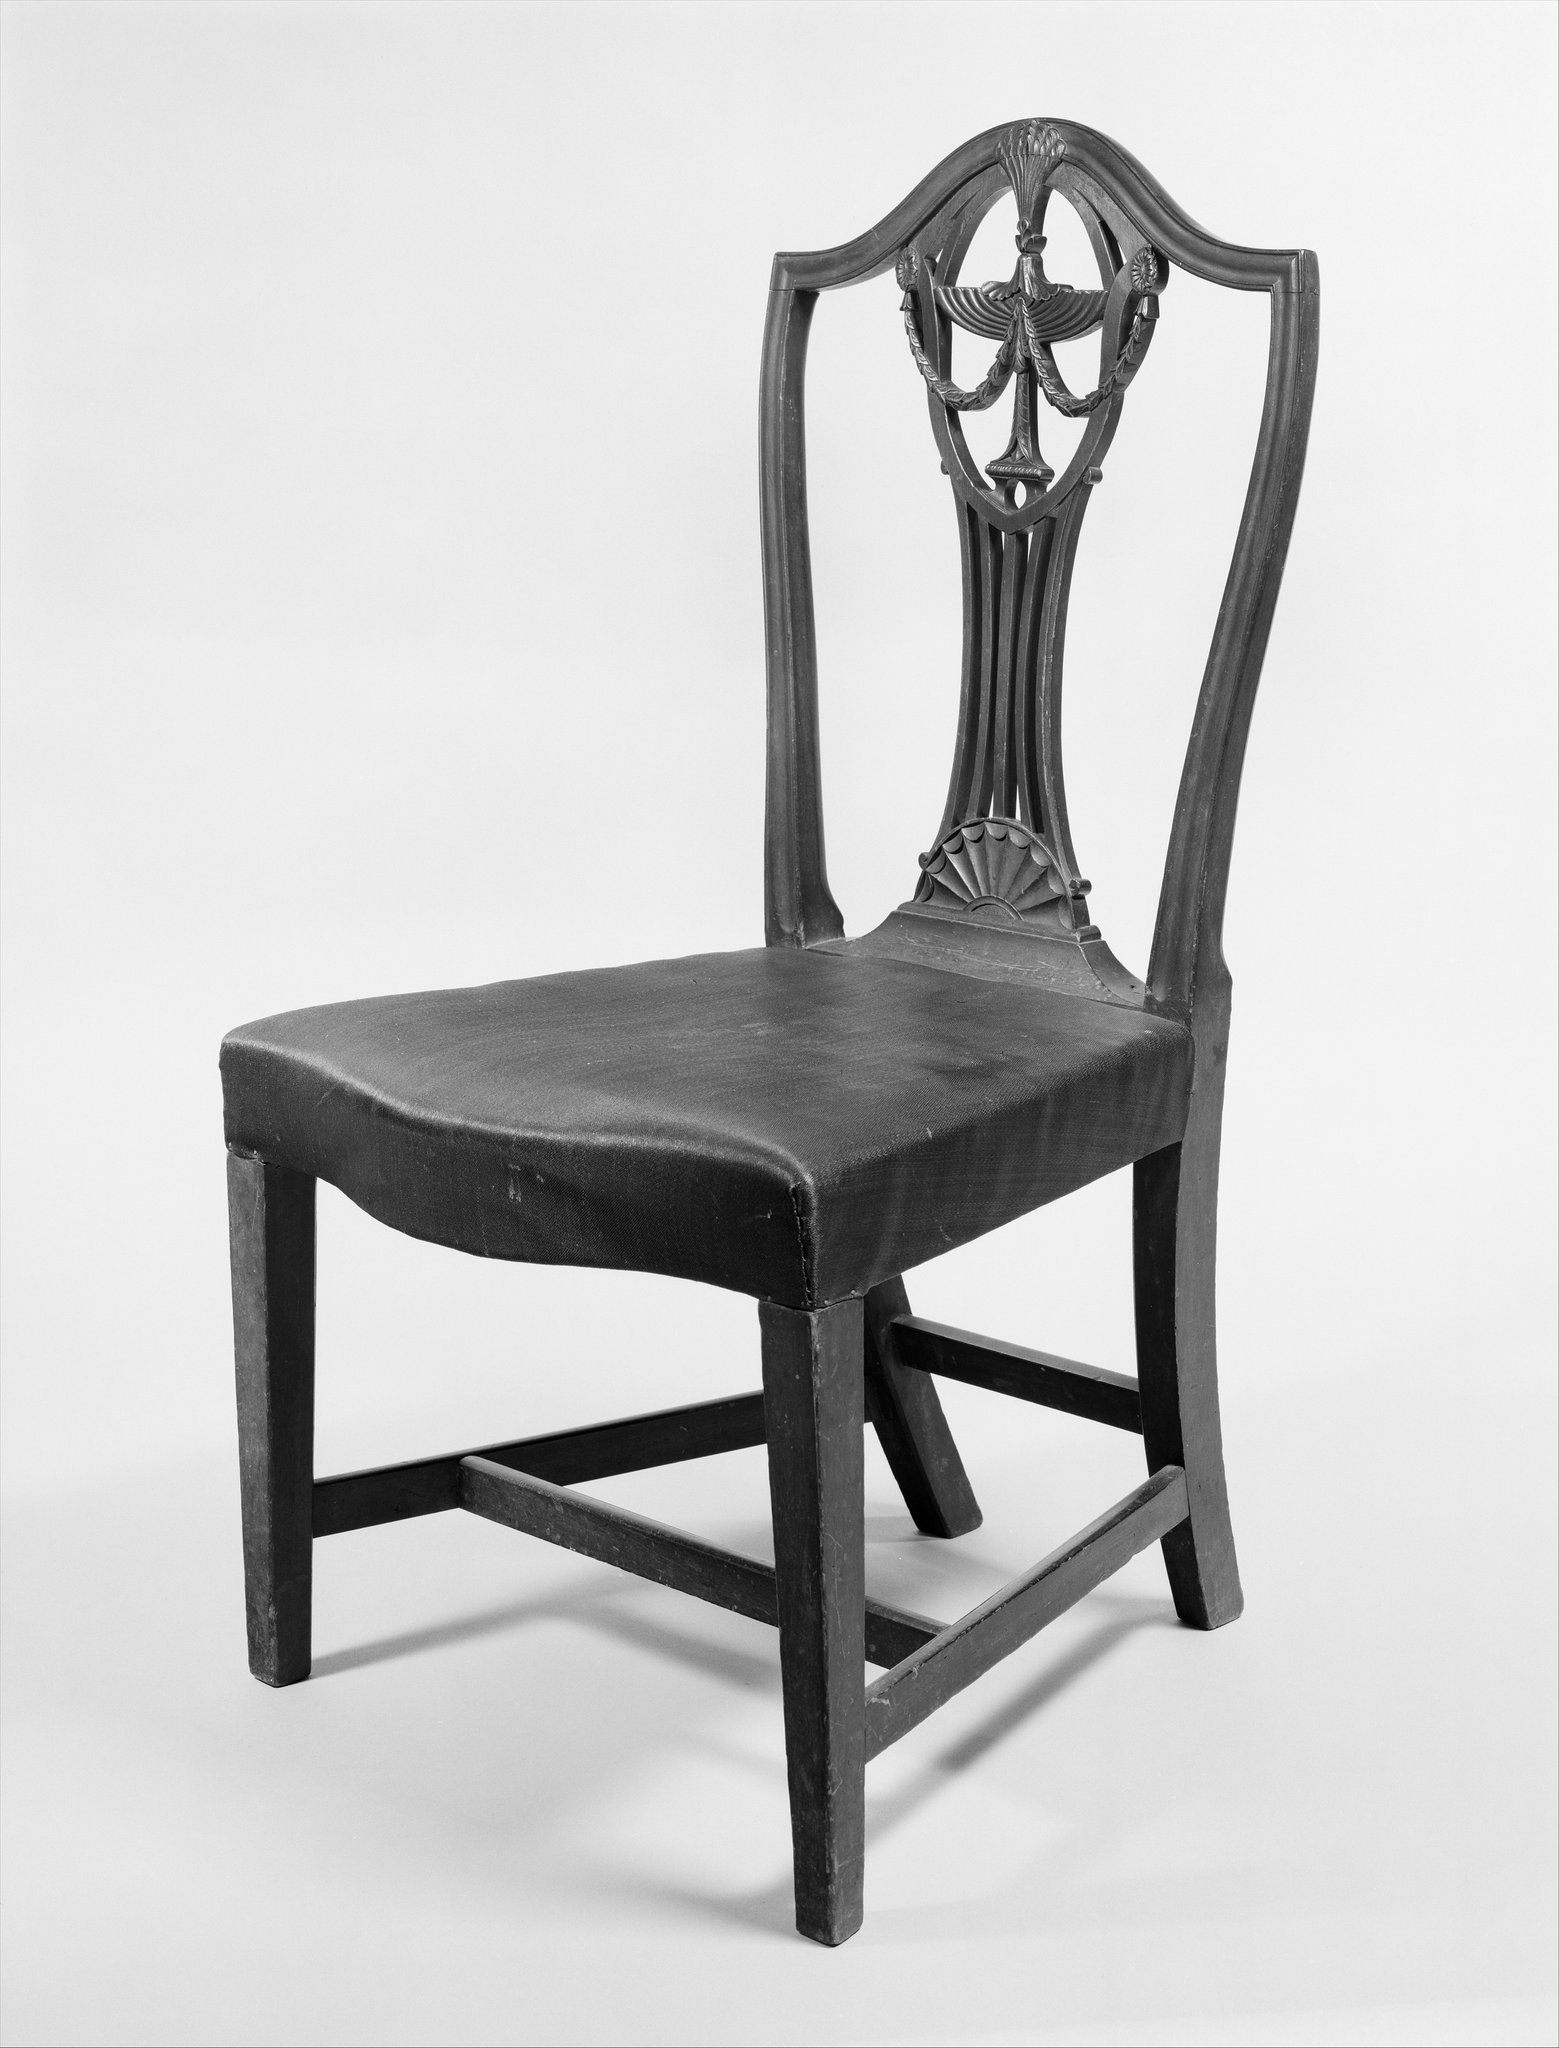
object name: chair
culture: american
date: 1790-1810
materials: wood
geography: united states